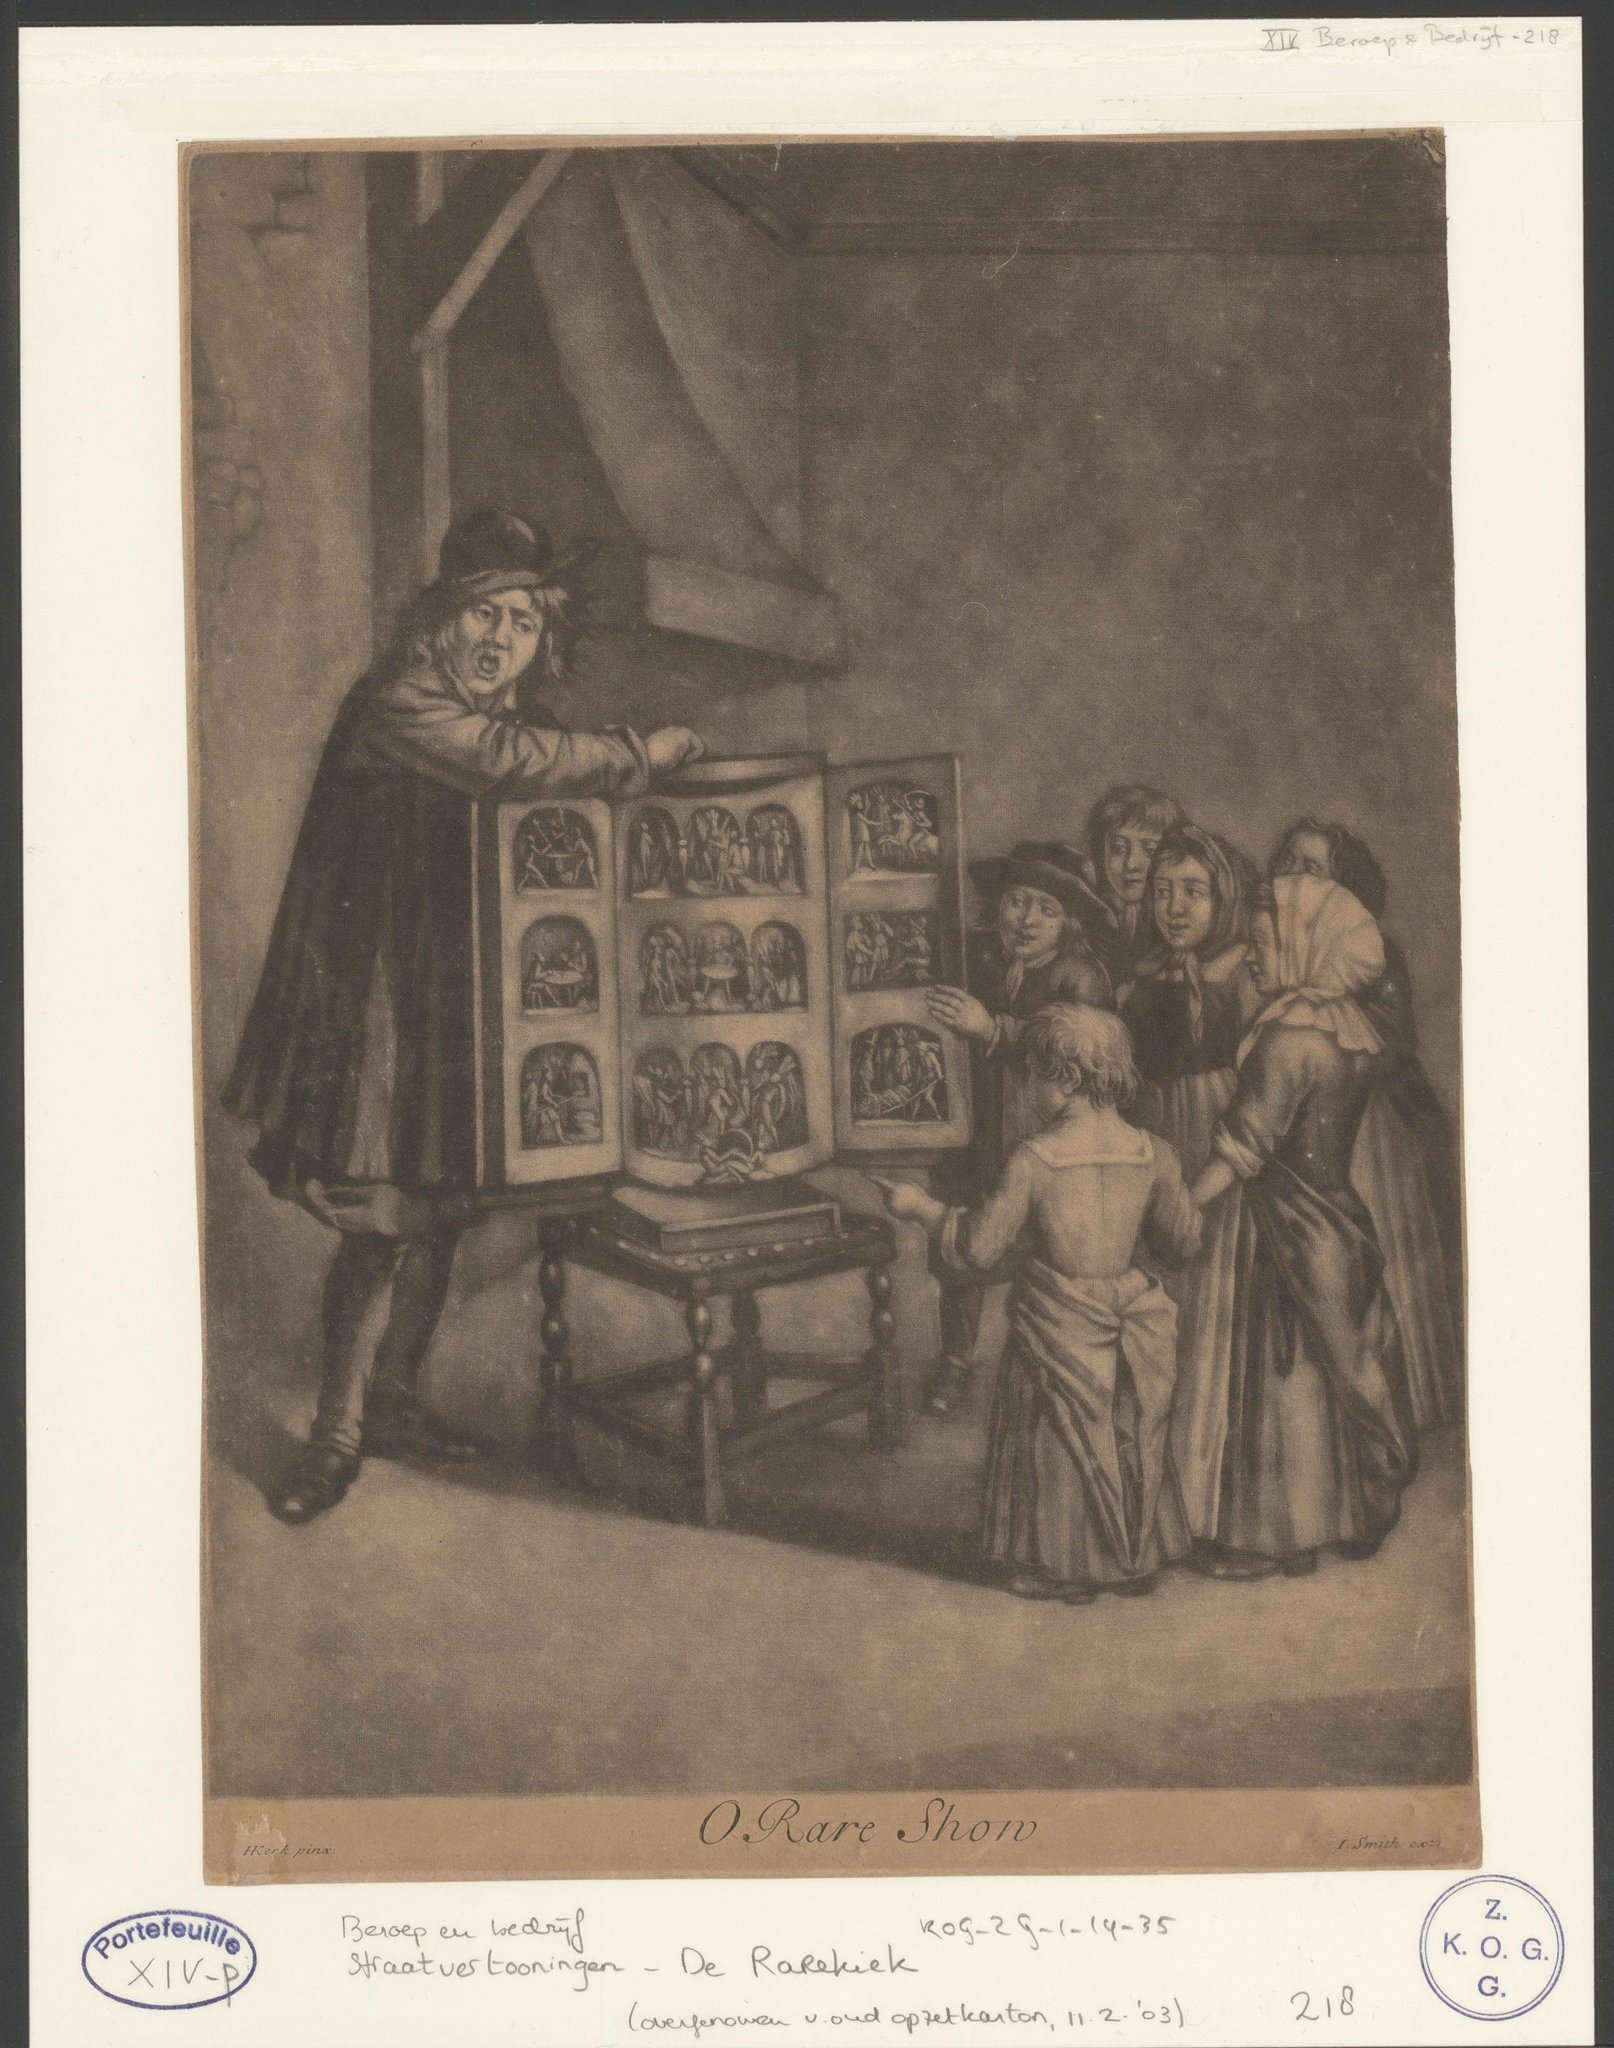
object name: print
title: Zes kinderen rond een kijkkast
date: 1680-1700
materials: paper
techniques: mezzotint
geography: london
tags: children's games and plays, street-trader, peep-show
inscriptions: collector's mark: Lugt 1641, collector's mark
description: Zes kinderen rond een kijkkast, een rarekiek, opengehouden en toegelicht door een rondreizende artiest. Onderwerpsrubrieken binnen de Atlas Zeden en Gewoonten: Mannelijk beroep en bedrijf: Marskramers, straatventers, straatslijpers, bedelaars, straatvertooningen enz.